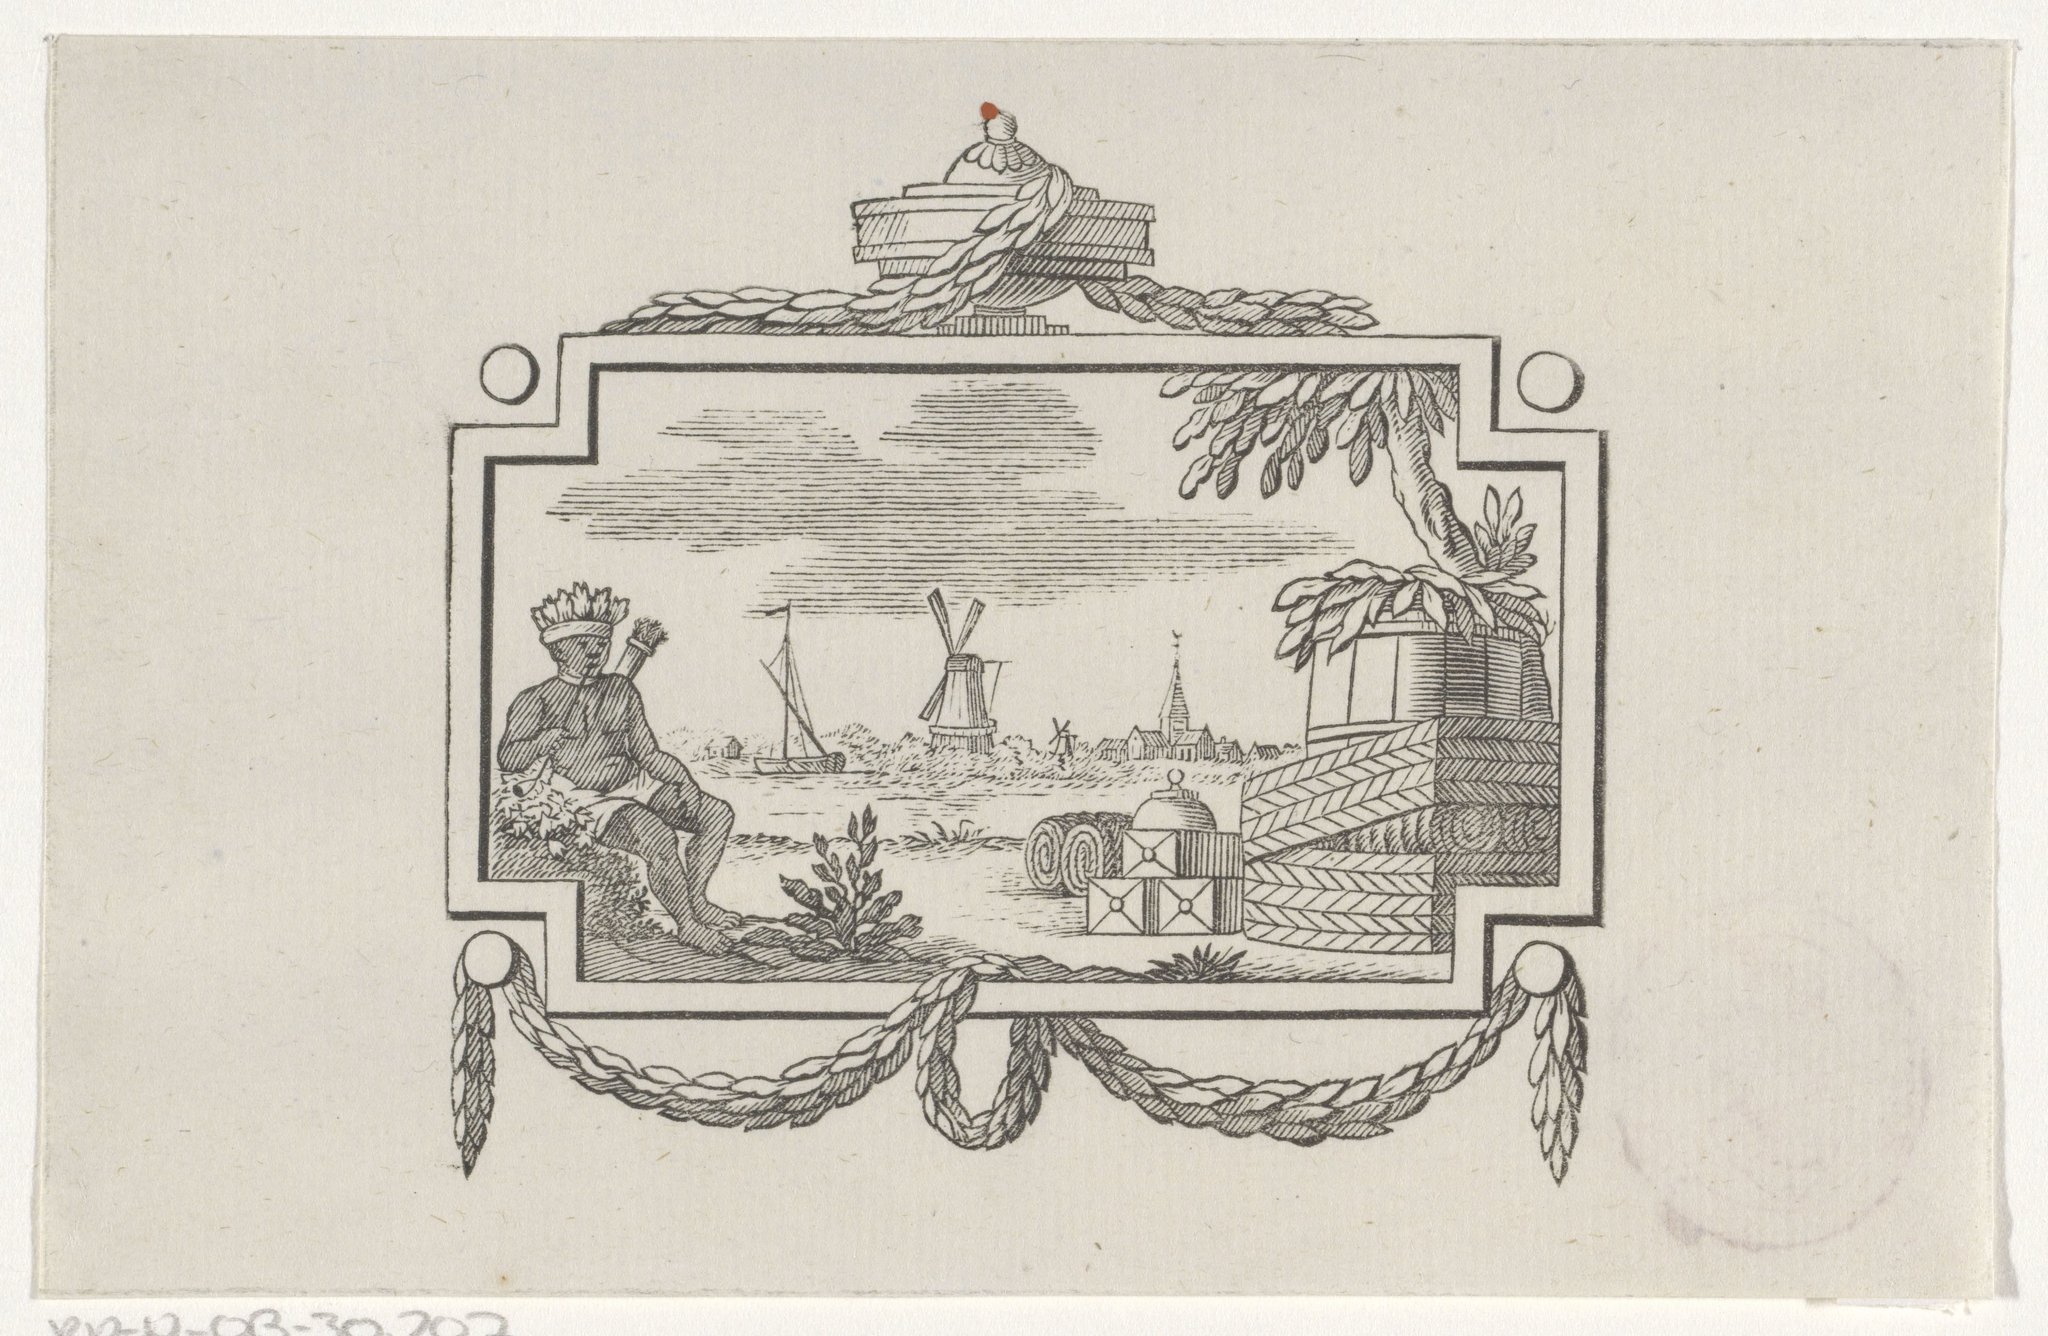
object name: print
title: Vignet voor de tabakshandel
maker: hendrik numan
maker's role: draughtsman, print maker, publisher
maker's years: 1736-1788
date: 1746-1788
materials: paper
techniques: woodcut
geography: haarlem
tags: prospect of village, silhouette of village, ships (in general), windmill in landscape, human races, peoples and nationalities (other than prehistoric or extinct), native peoples of the americas, landscapes (+ landscape with figures, staffage)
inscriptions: collector's mark: Lugt 240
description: Een oorspronkelijke bewoner van Amerika zit in een Hollands landschap en rookt een pijp. Rechts tabak in allerlei vormen.